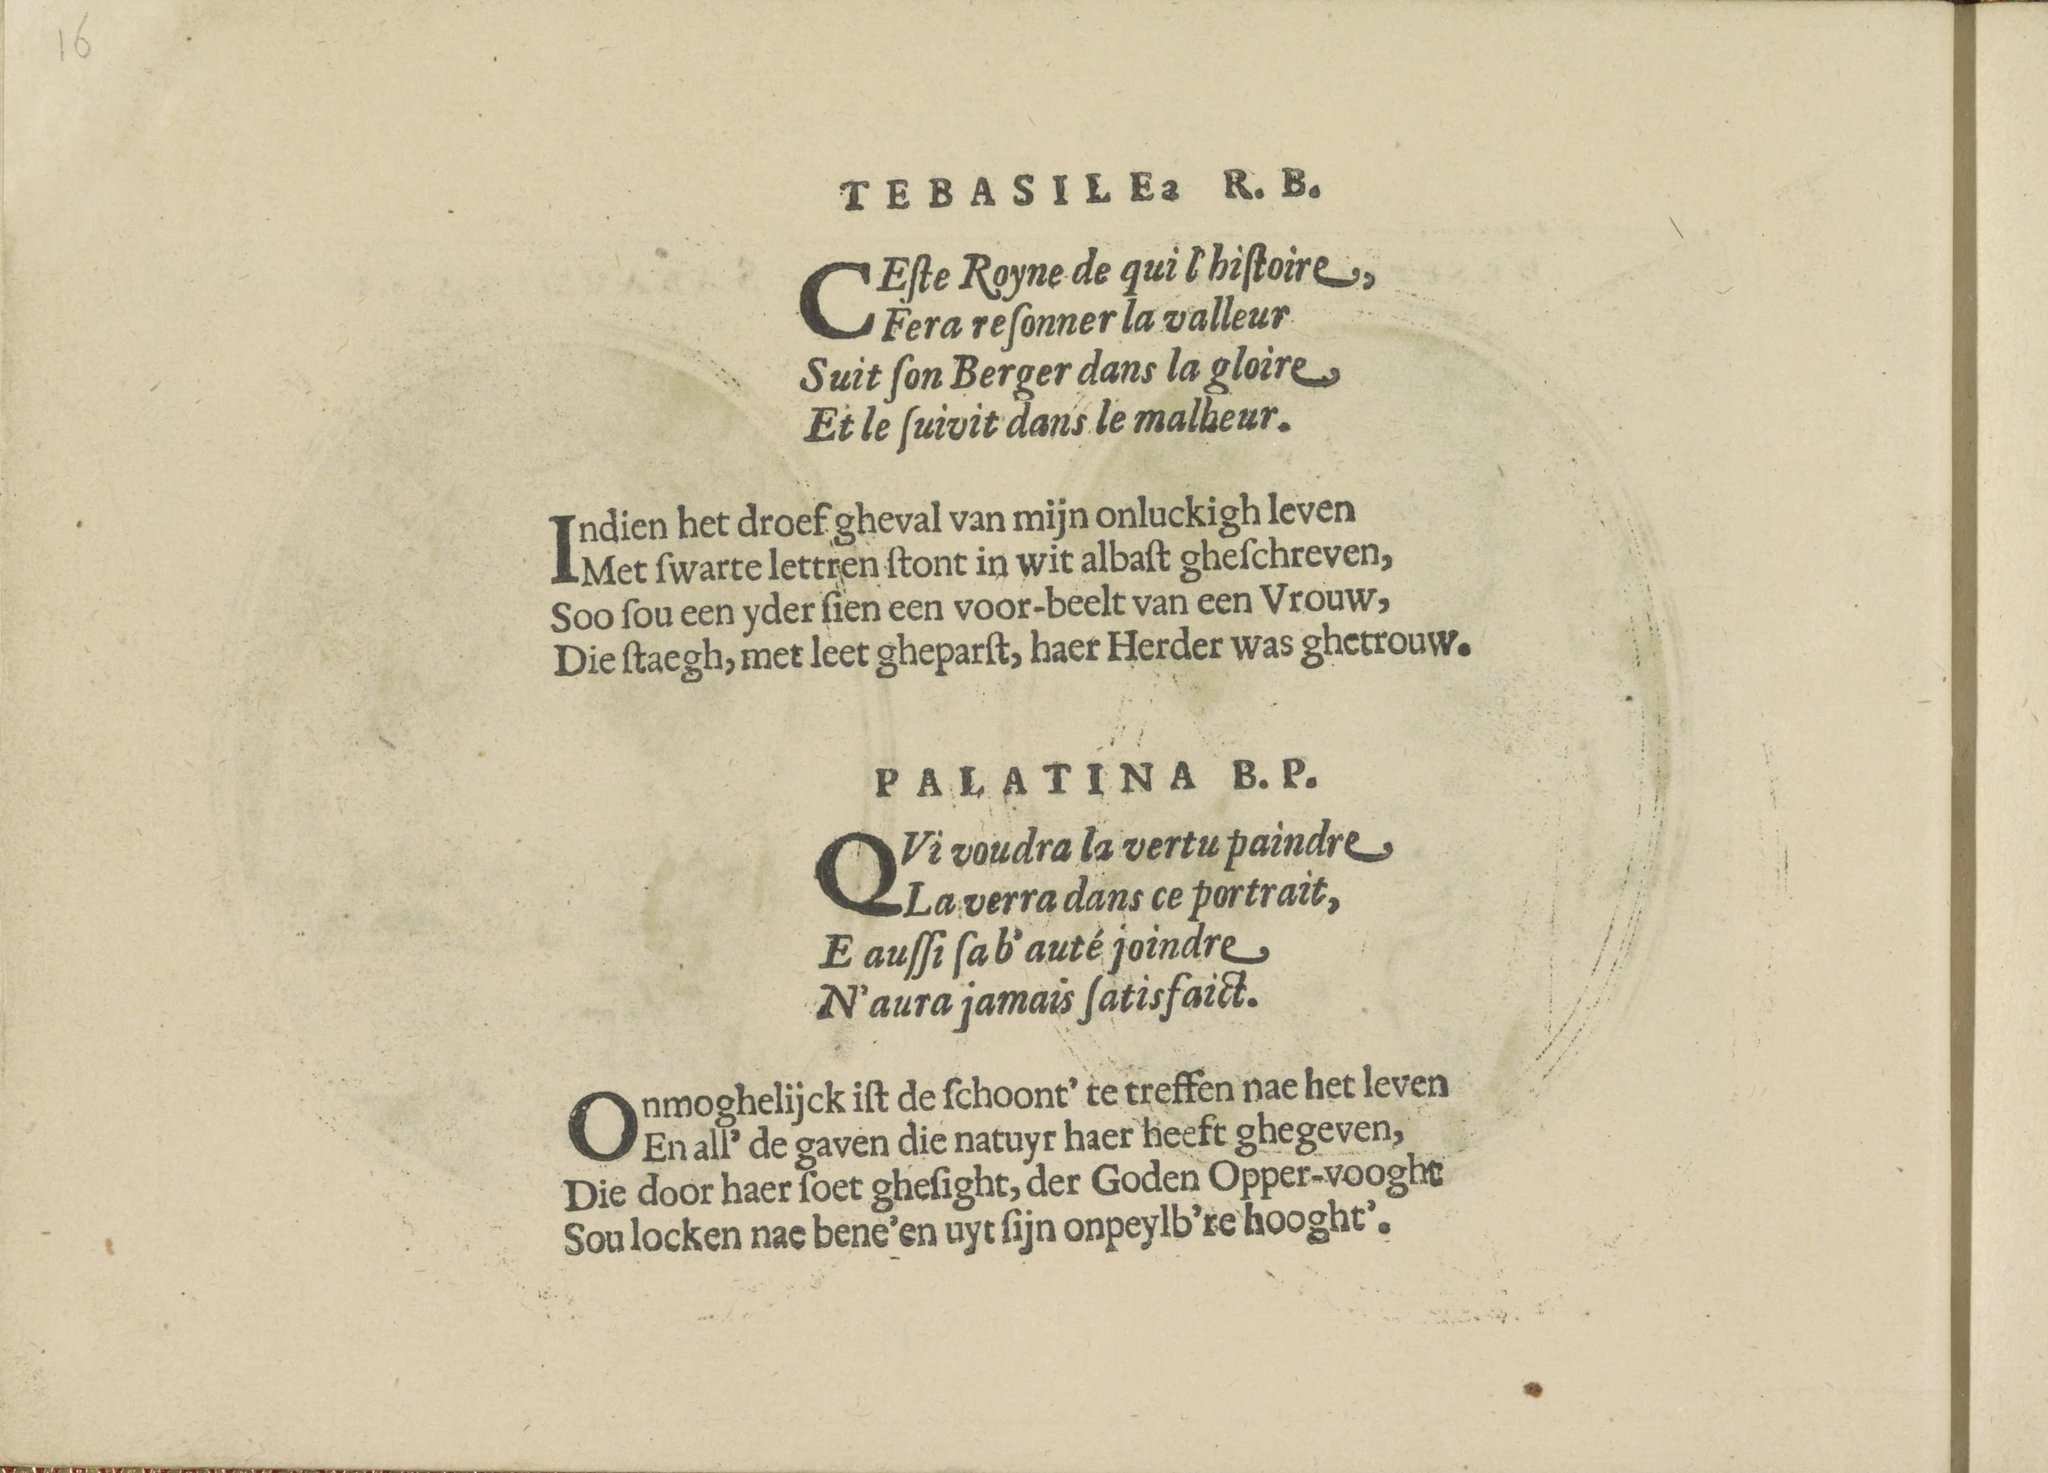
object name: text sheet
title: Kwatrijnen bij de voorstellingen van Tebasilea R.B. en Palatina B.P.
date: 1640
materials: paper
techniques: letterpress printing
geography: amsterdam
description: Twee keer twee kwatrijnen in het Frans en Nederlands bij de voorstellingen van Tebasilea R.B. en Palatina B.P. Het blad maakt deel uit van een album.